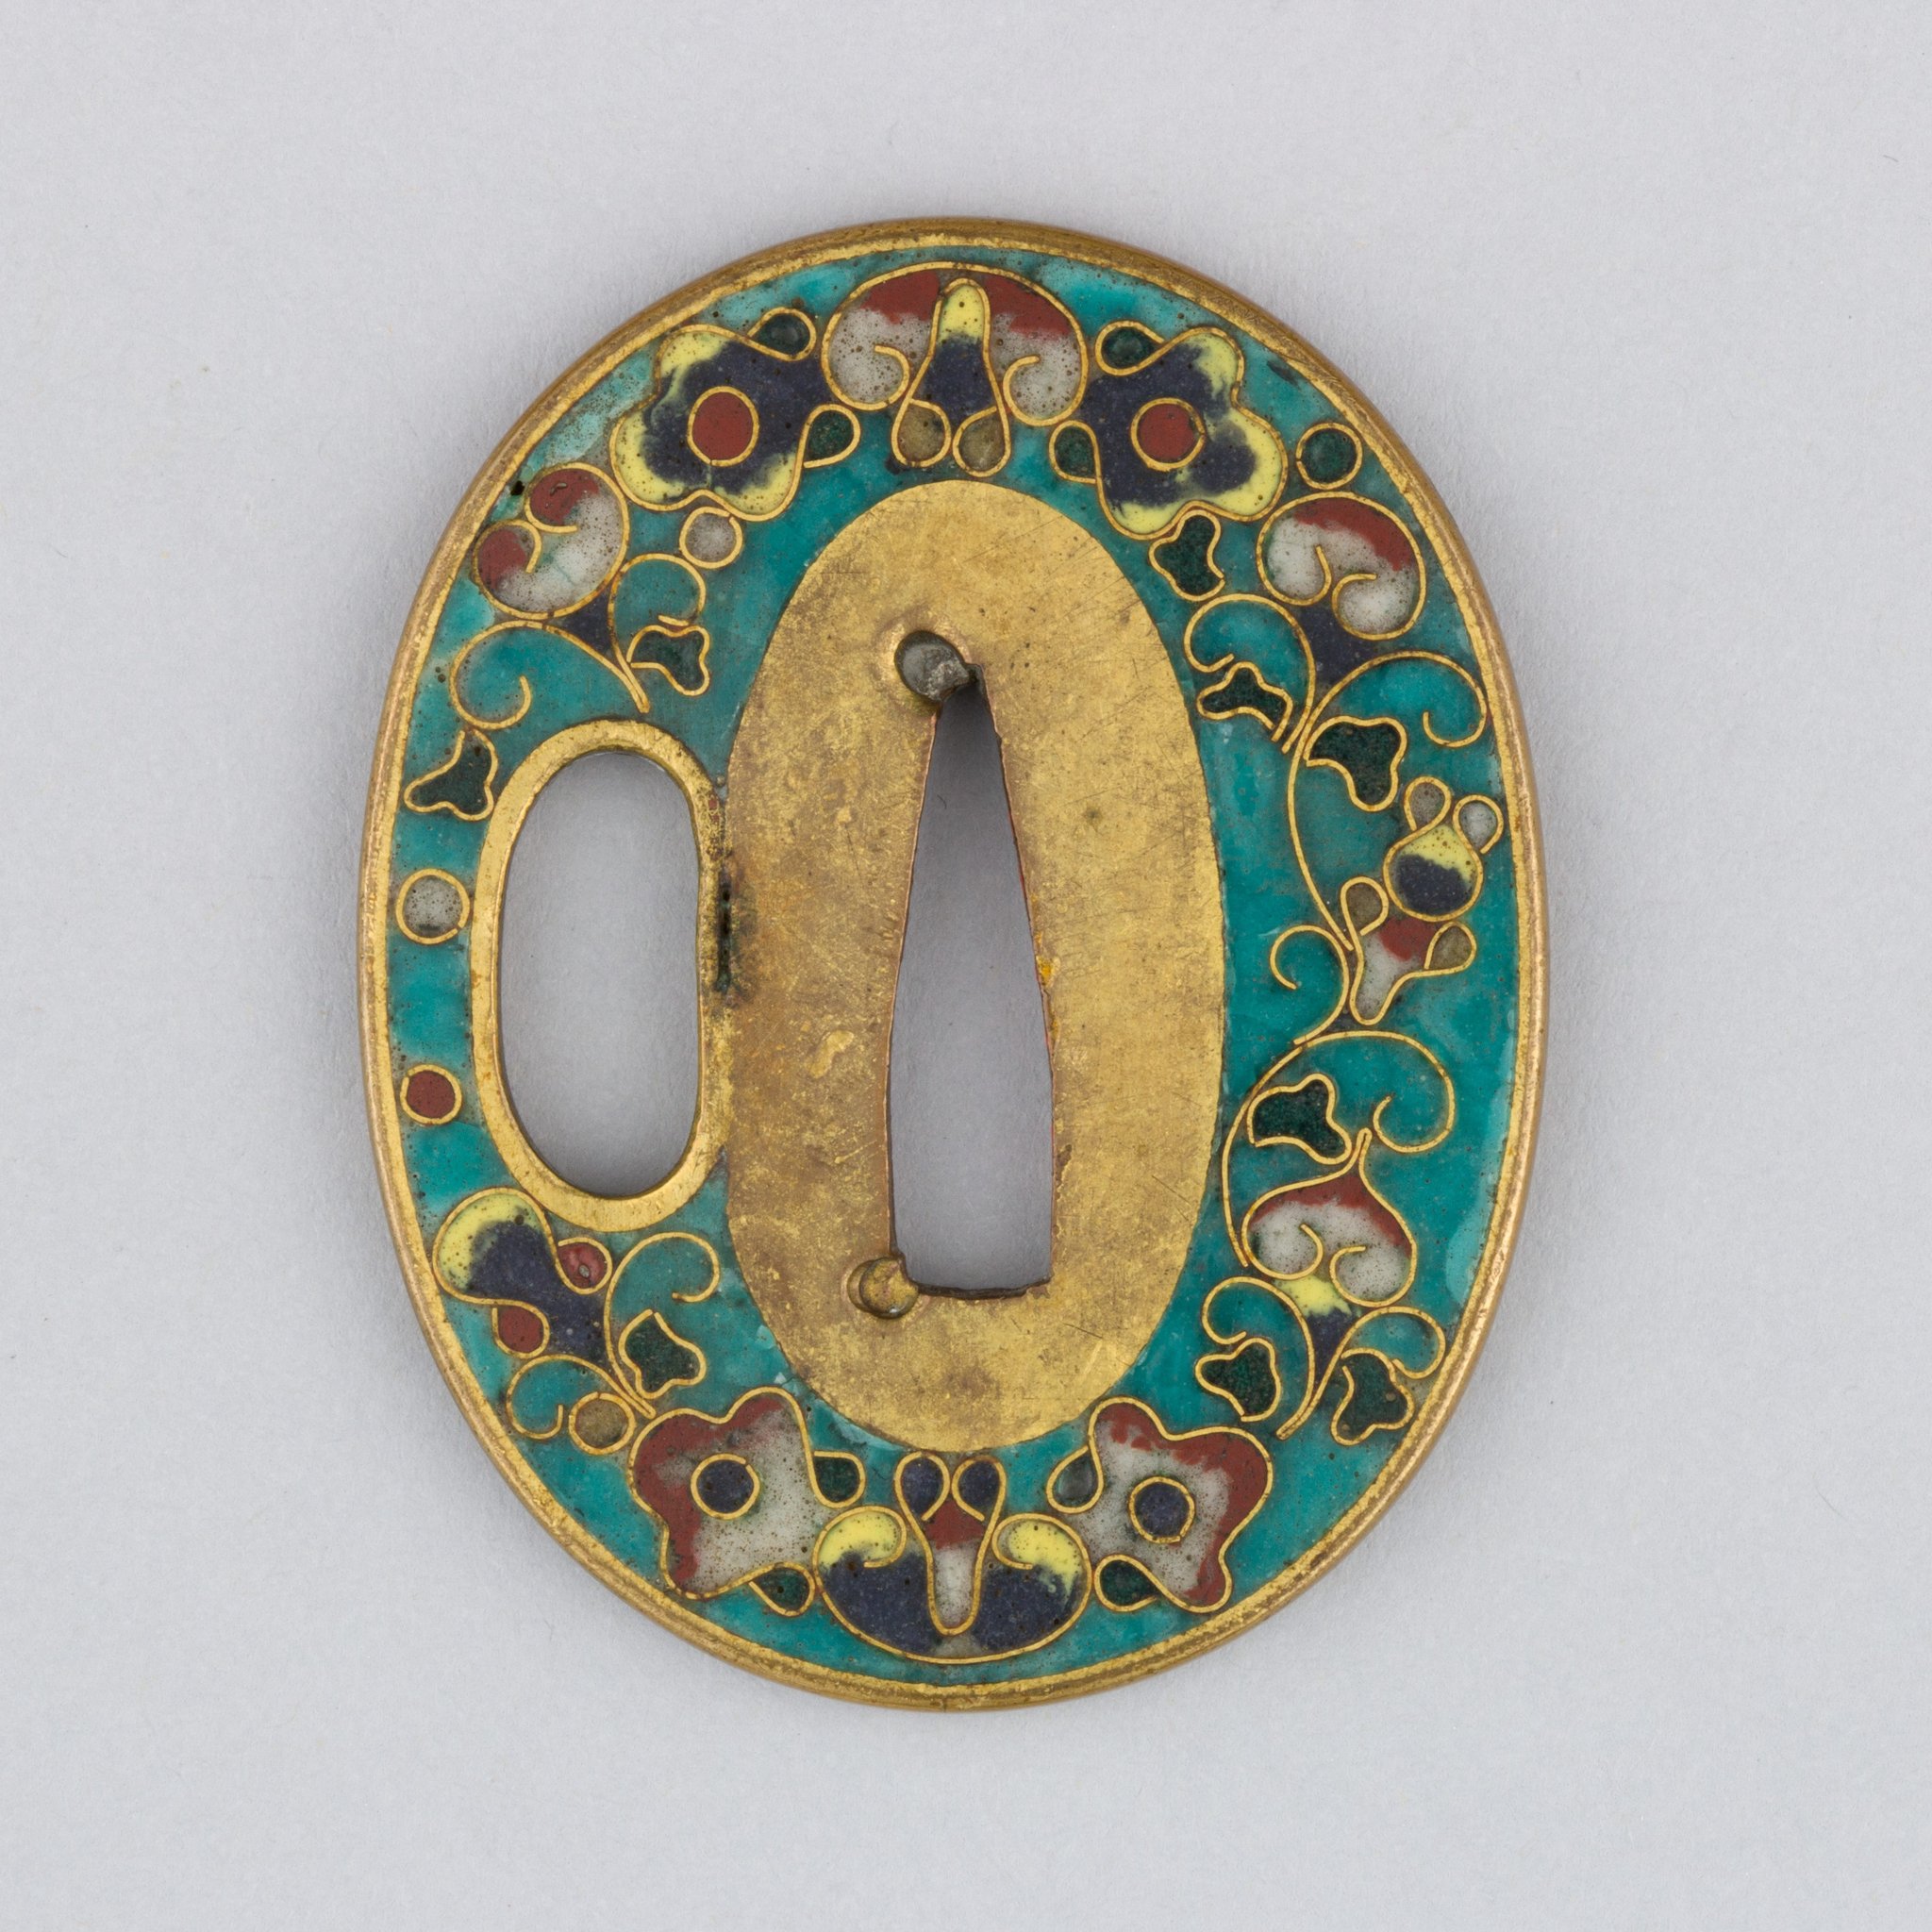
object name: sword guard tsuba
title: Sword Guard (Tsuba)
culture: japanese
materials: brass, copper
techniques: enamel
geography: japan